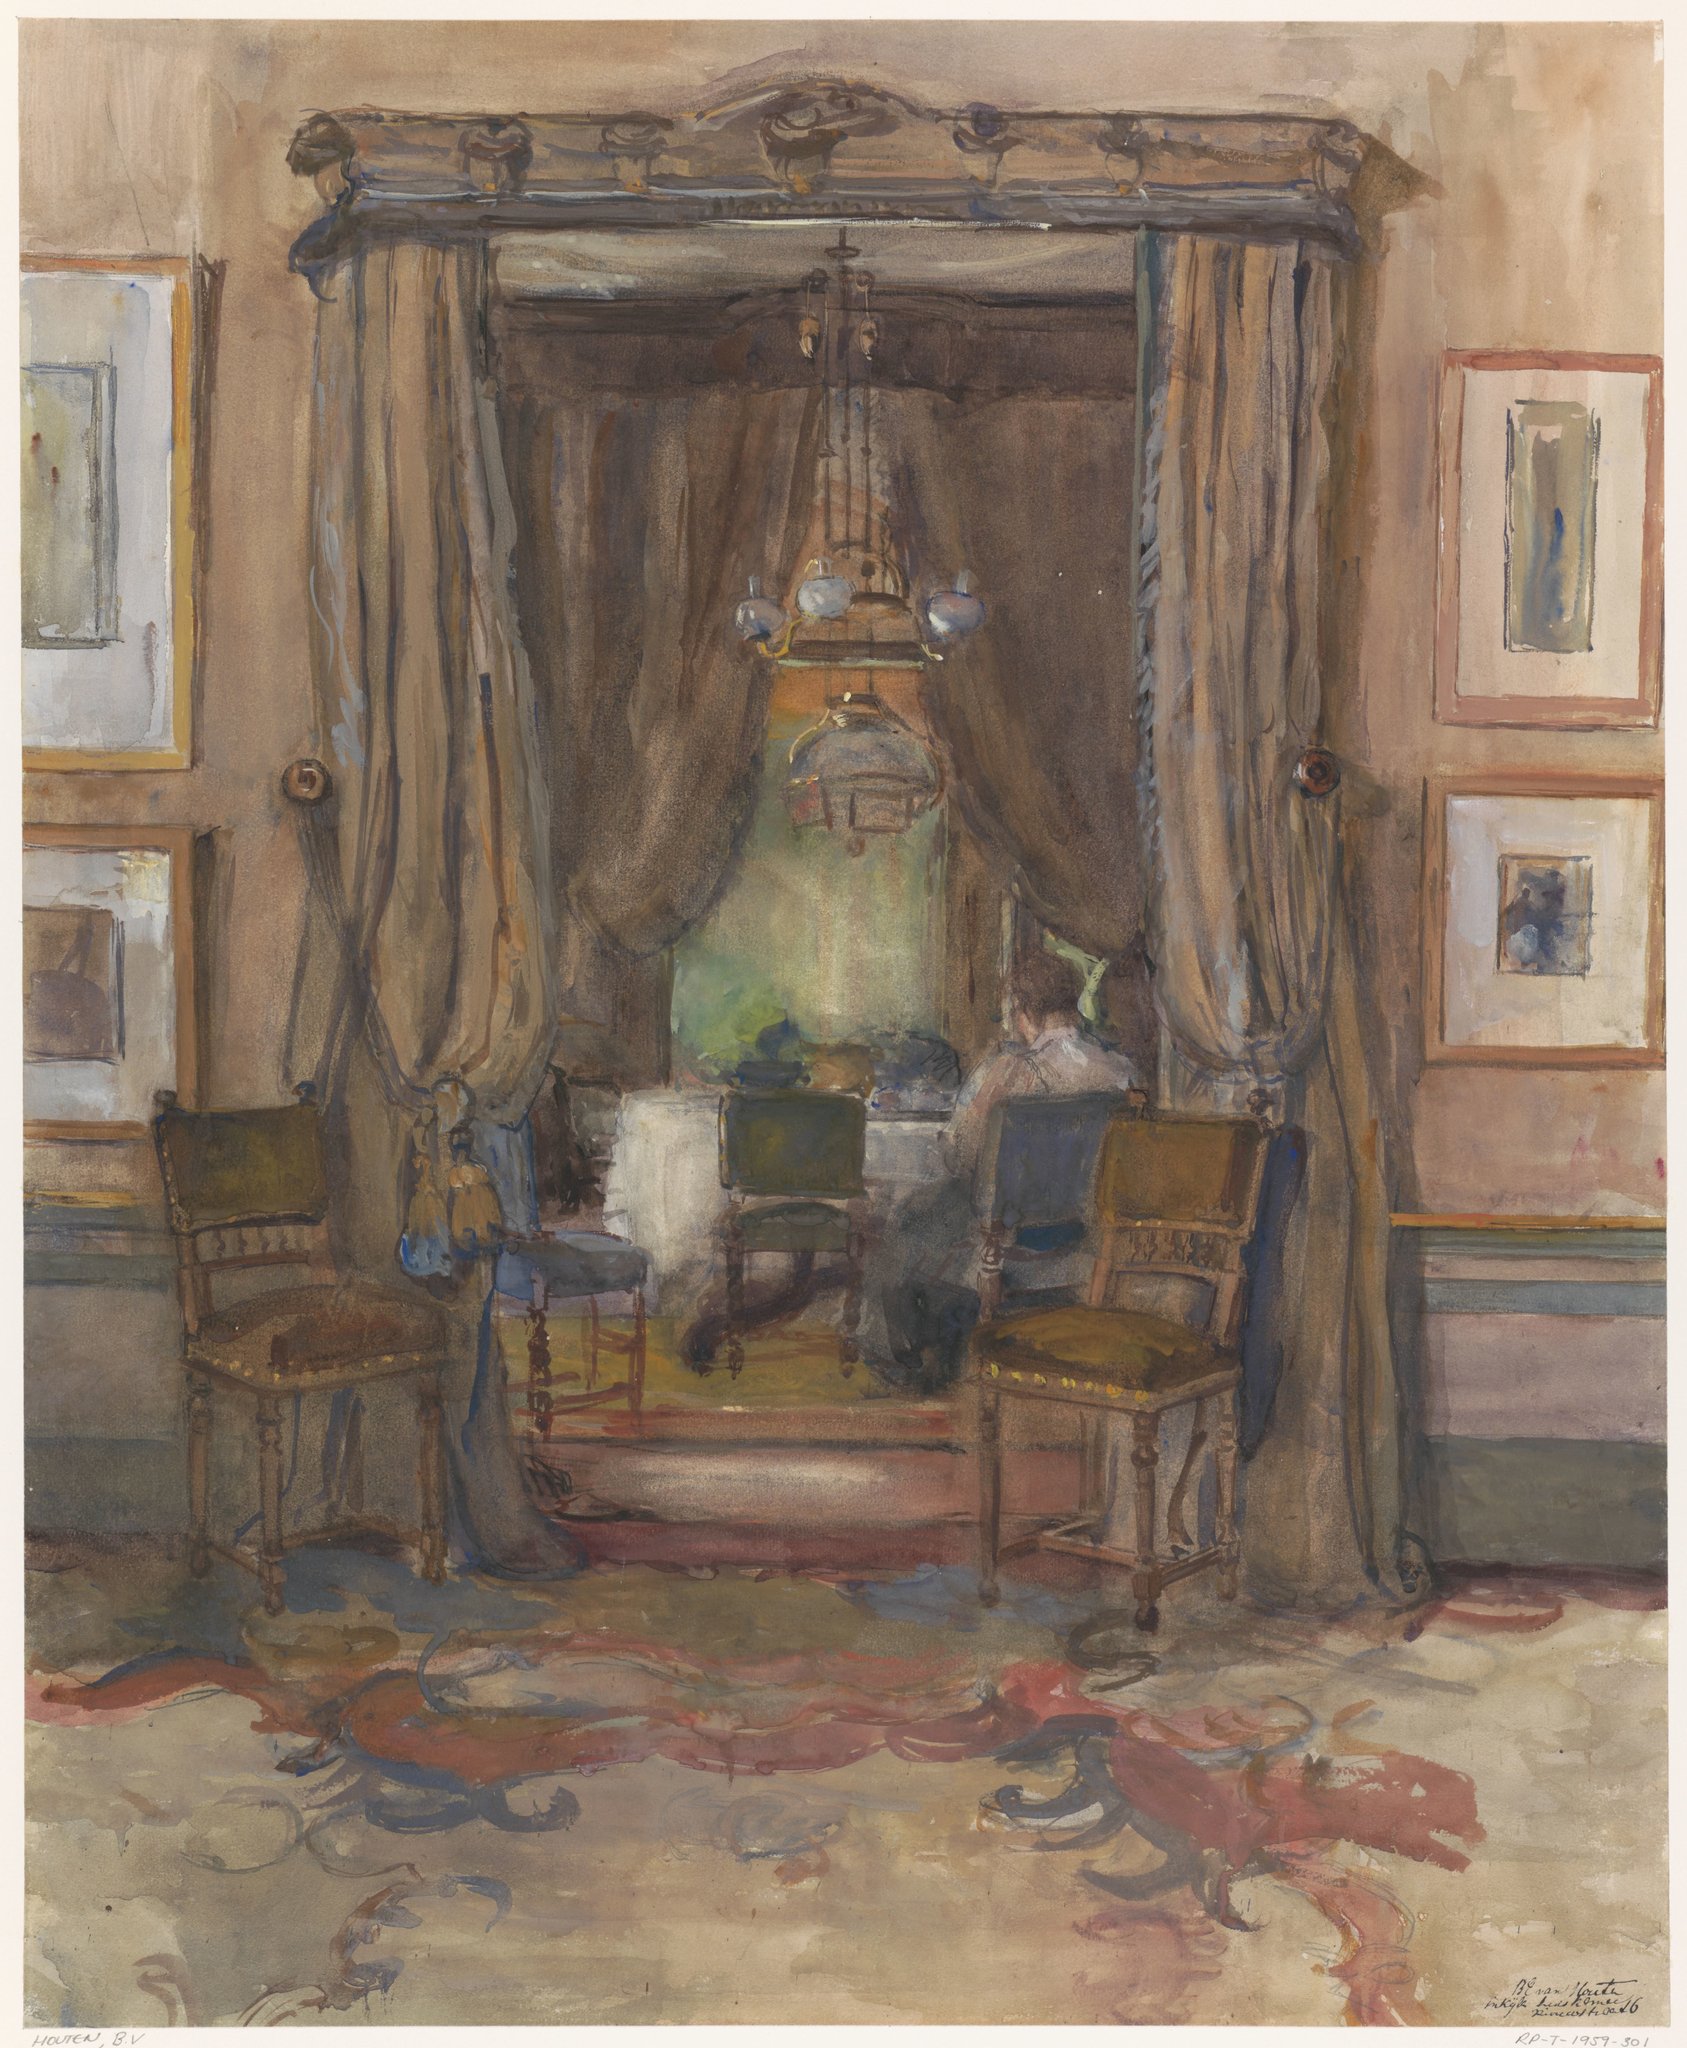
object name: watercolor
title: De huiskamer aan de Riouwstraat te Den Haag, bij daglicht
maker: barbara elisabeth van houten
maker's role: draughtsman, print maker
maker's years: 1862-1950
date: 1872-1950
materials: paper, pencil, watercolor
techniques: brush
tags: living-room, parlour, sitting-room, the hague